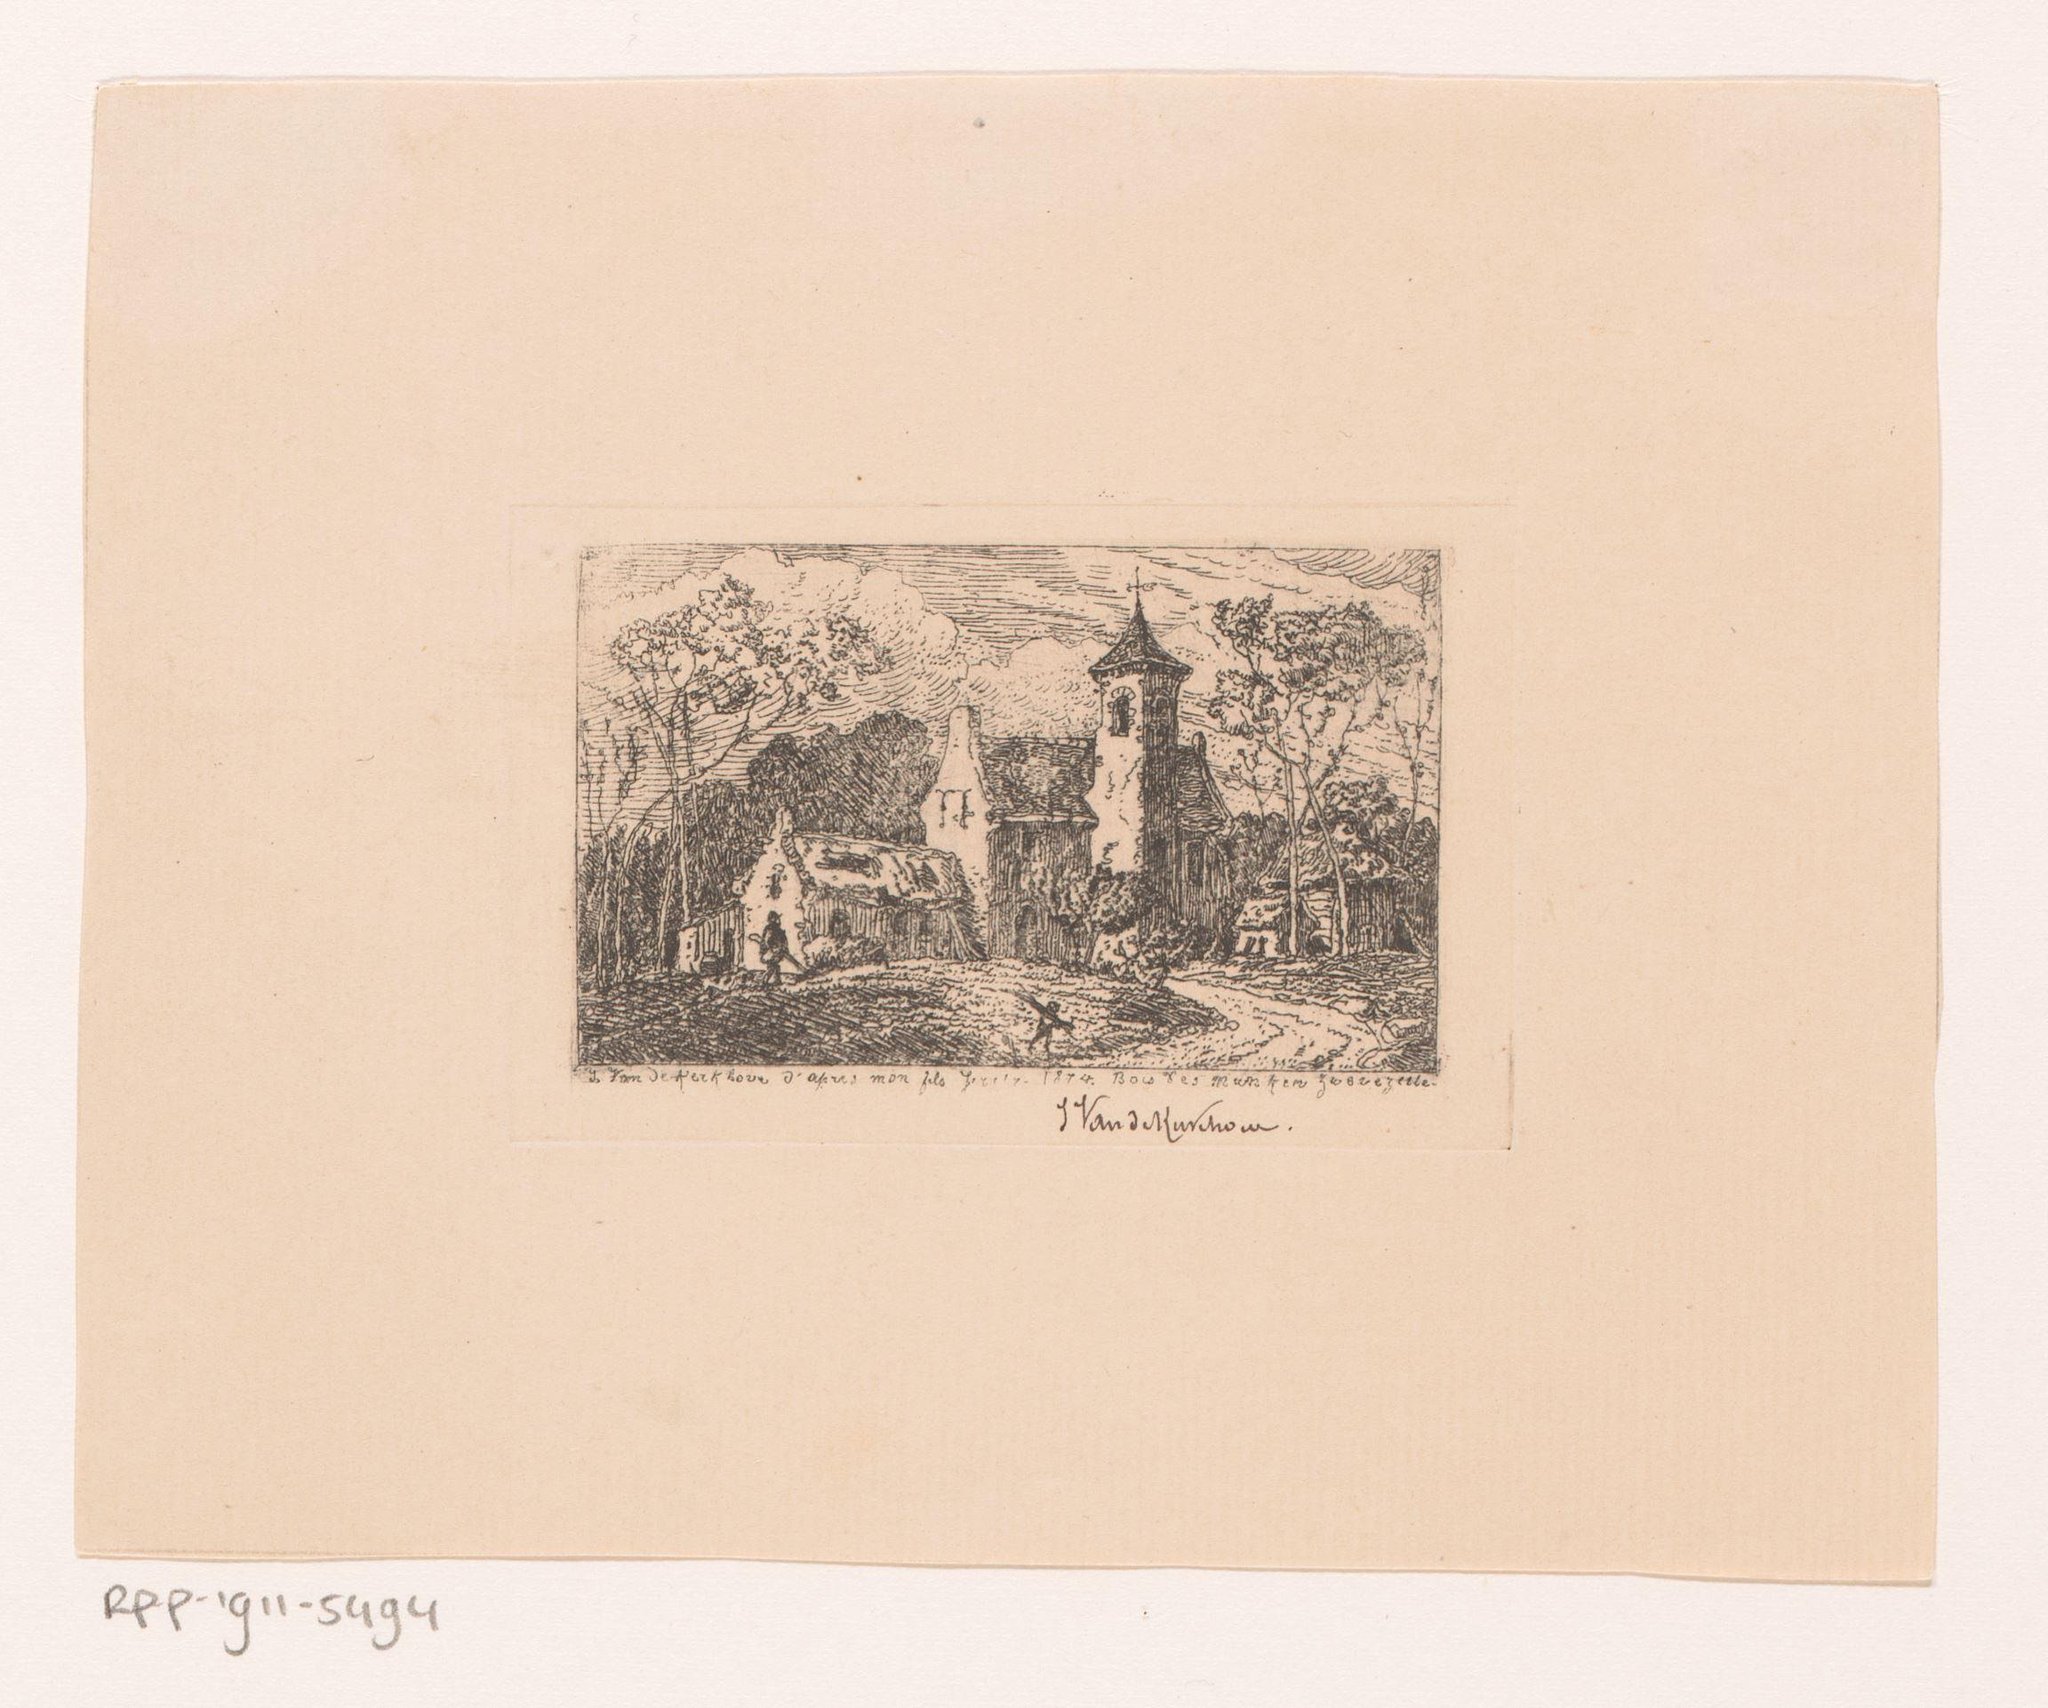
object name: print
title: Kasteelachtig huis in het bos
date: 1874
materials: paper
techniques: etching, intaglio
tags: landscape with tower or castle (+ city(-scape) with figures, staffage)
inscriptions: collector's mark: Lugt 2228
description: De etsen naar de schilderijen van Frédéric Van de Kerkhove werden na zijn dood door zijn vader en zuster gemaakt en uitgegeven in twee reeksen. De eerste werd in 1877 uitgegeven door het Journal des Beaux-Arts et de la Littérature: Cahier de 25 Eaux-fortes d'après Frédéric van de Kerkhove, gravées par son père et sa sœur. De tweede reeks van 126 etsen, ook in 1877, werd in Parijs uitgegeven bij A. Lévy onder de titel Cent eaux-fortes gravées par J. Van de Kerkhove d'après les tableaux de Frédéric Van de Kerkhove, mort en 1873 à l'âge de 10 ans et 11 mois.